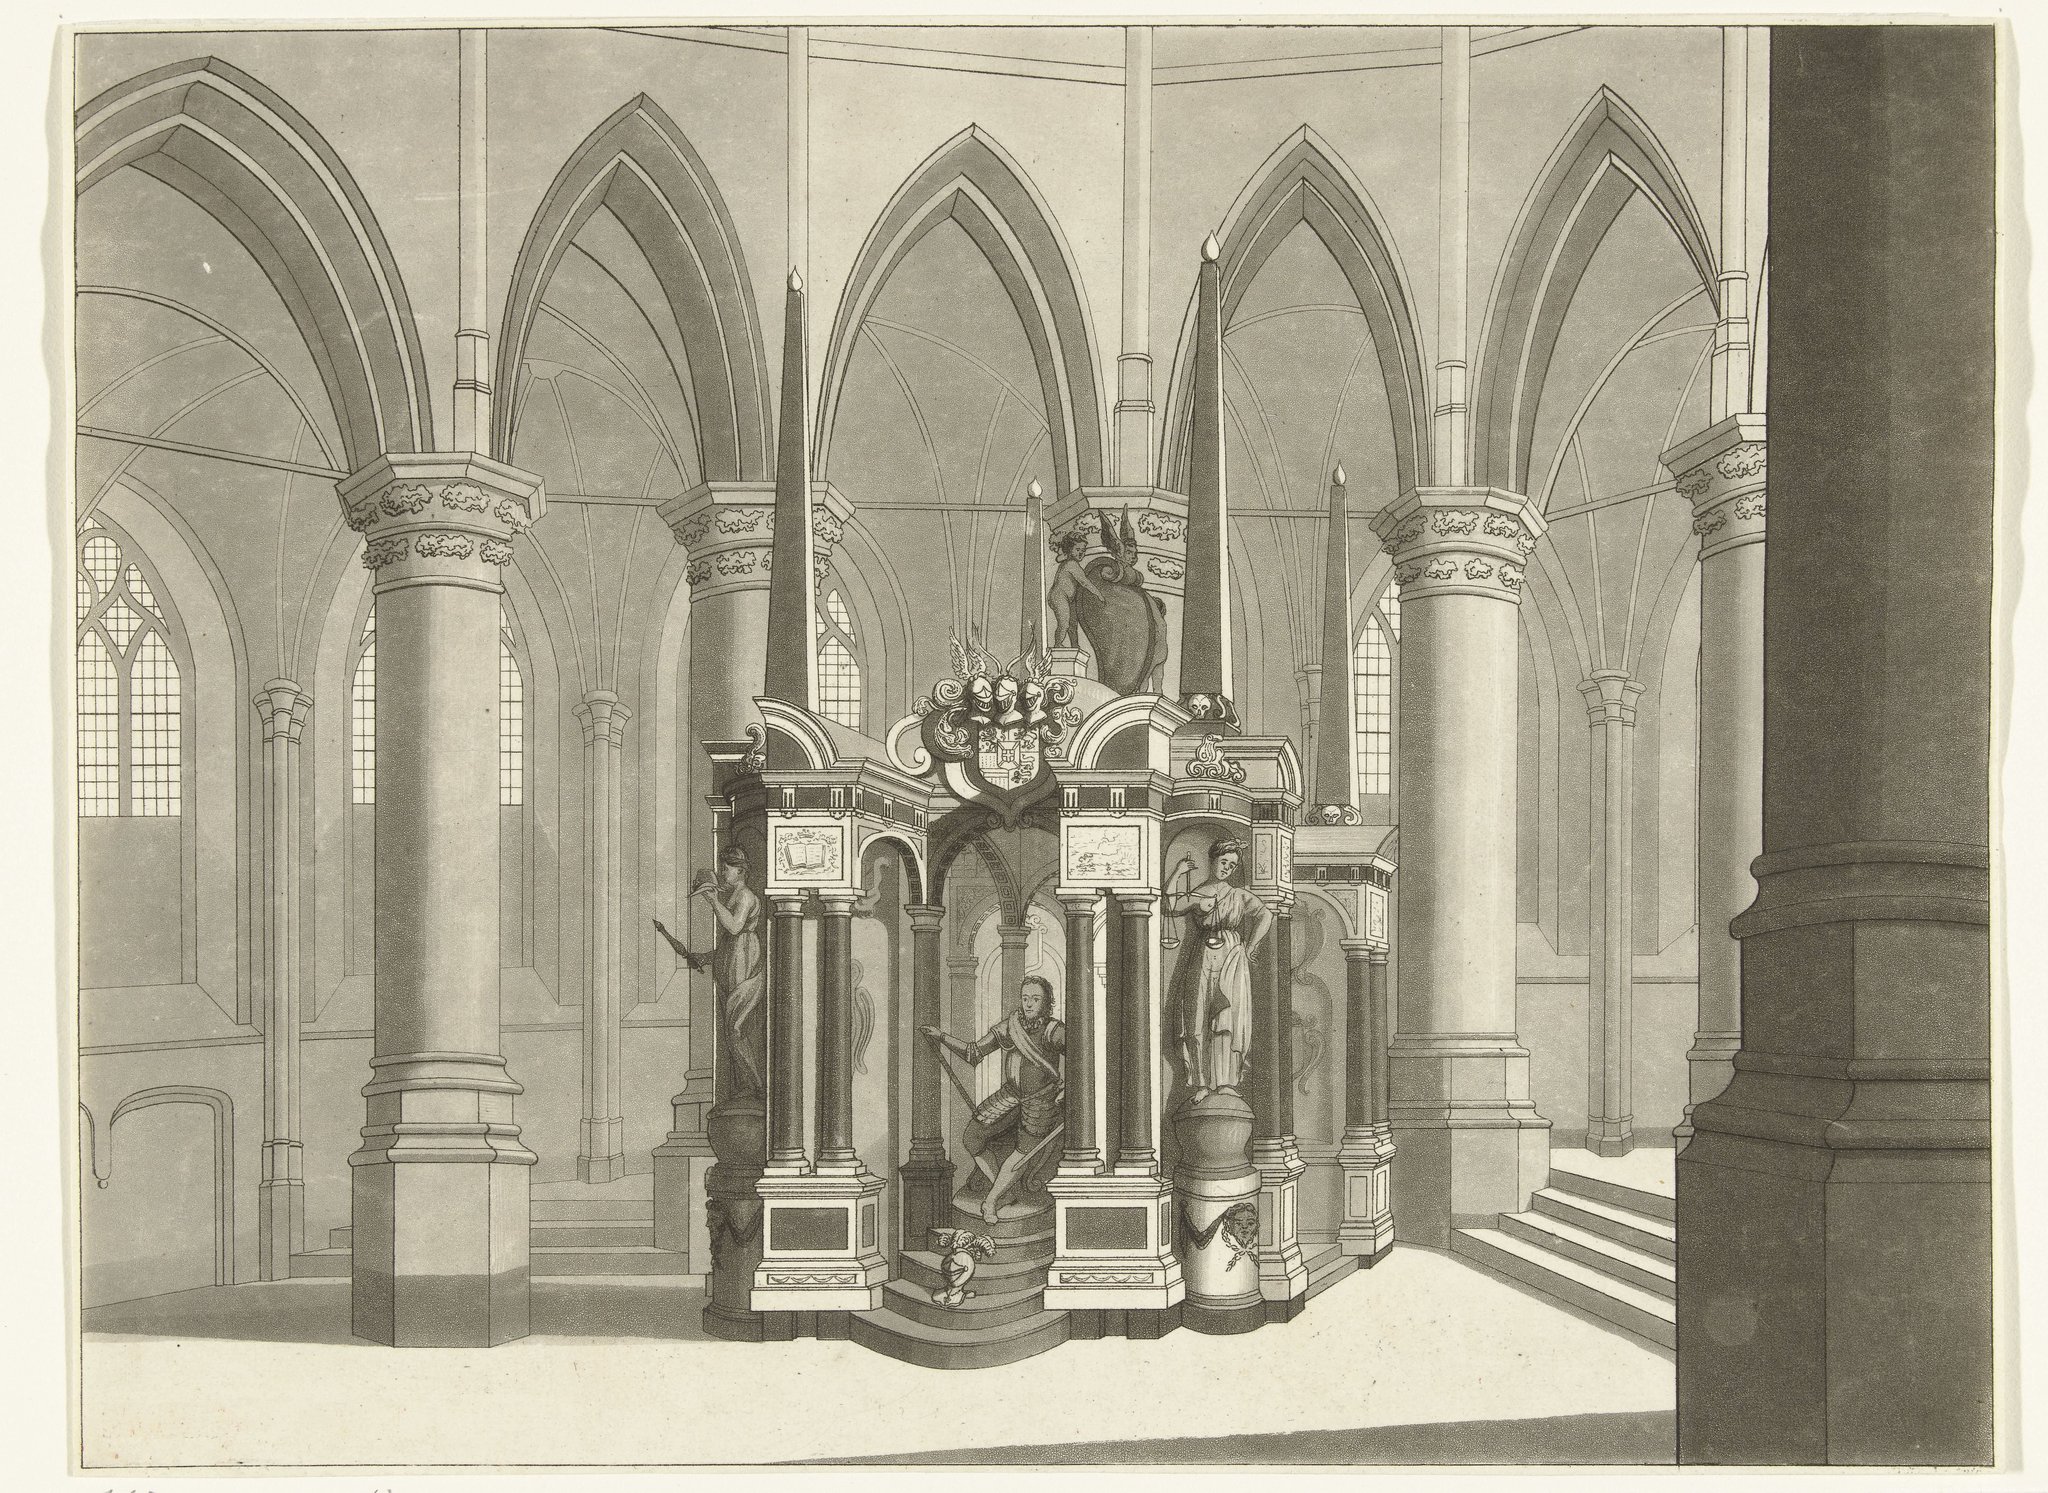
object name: print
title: Graftombe van Willem I, prins van Oranje, 1623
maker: johannes cornelis zürcher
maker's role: print maker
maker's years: 1794-1882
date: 1825-1828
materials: paper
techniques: aquatint, etching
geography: netherlands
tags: delft, william i (prince of orange), grave-building, monumental tomb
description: De hier vermelde titel verwijst naar de hoogst verkregen titel van de geportretteerde, niet per se naar de titel die de geportretteerde op deze voorstelling draagt. Gebruikt als illustratie in: B. Bruins, Nicolaas Godfried van Kampen, Korte beschrijving der stad Delft, B. Bruins, Delft 1828 (of 1827).